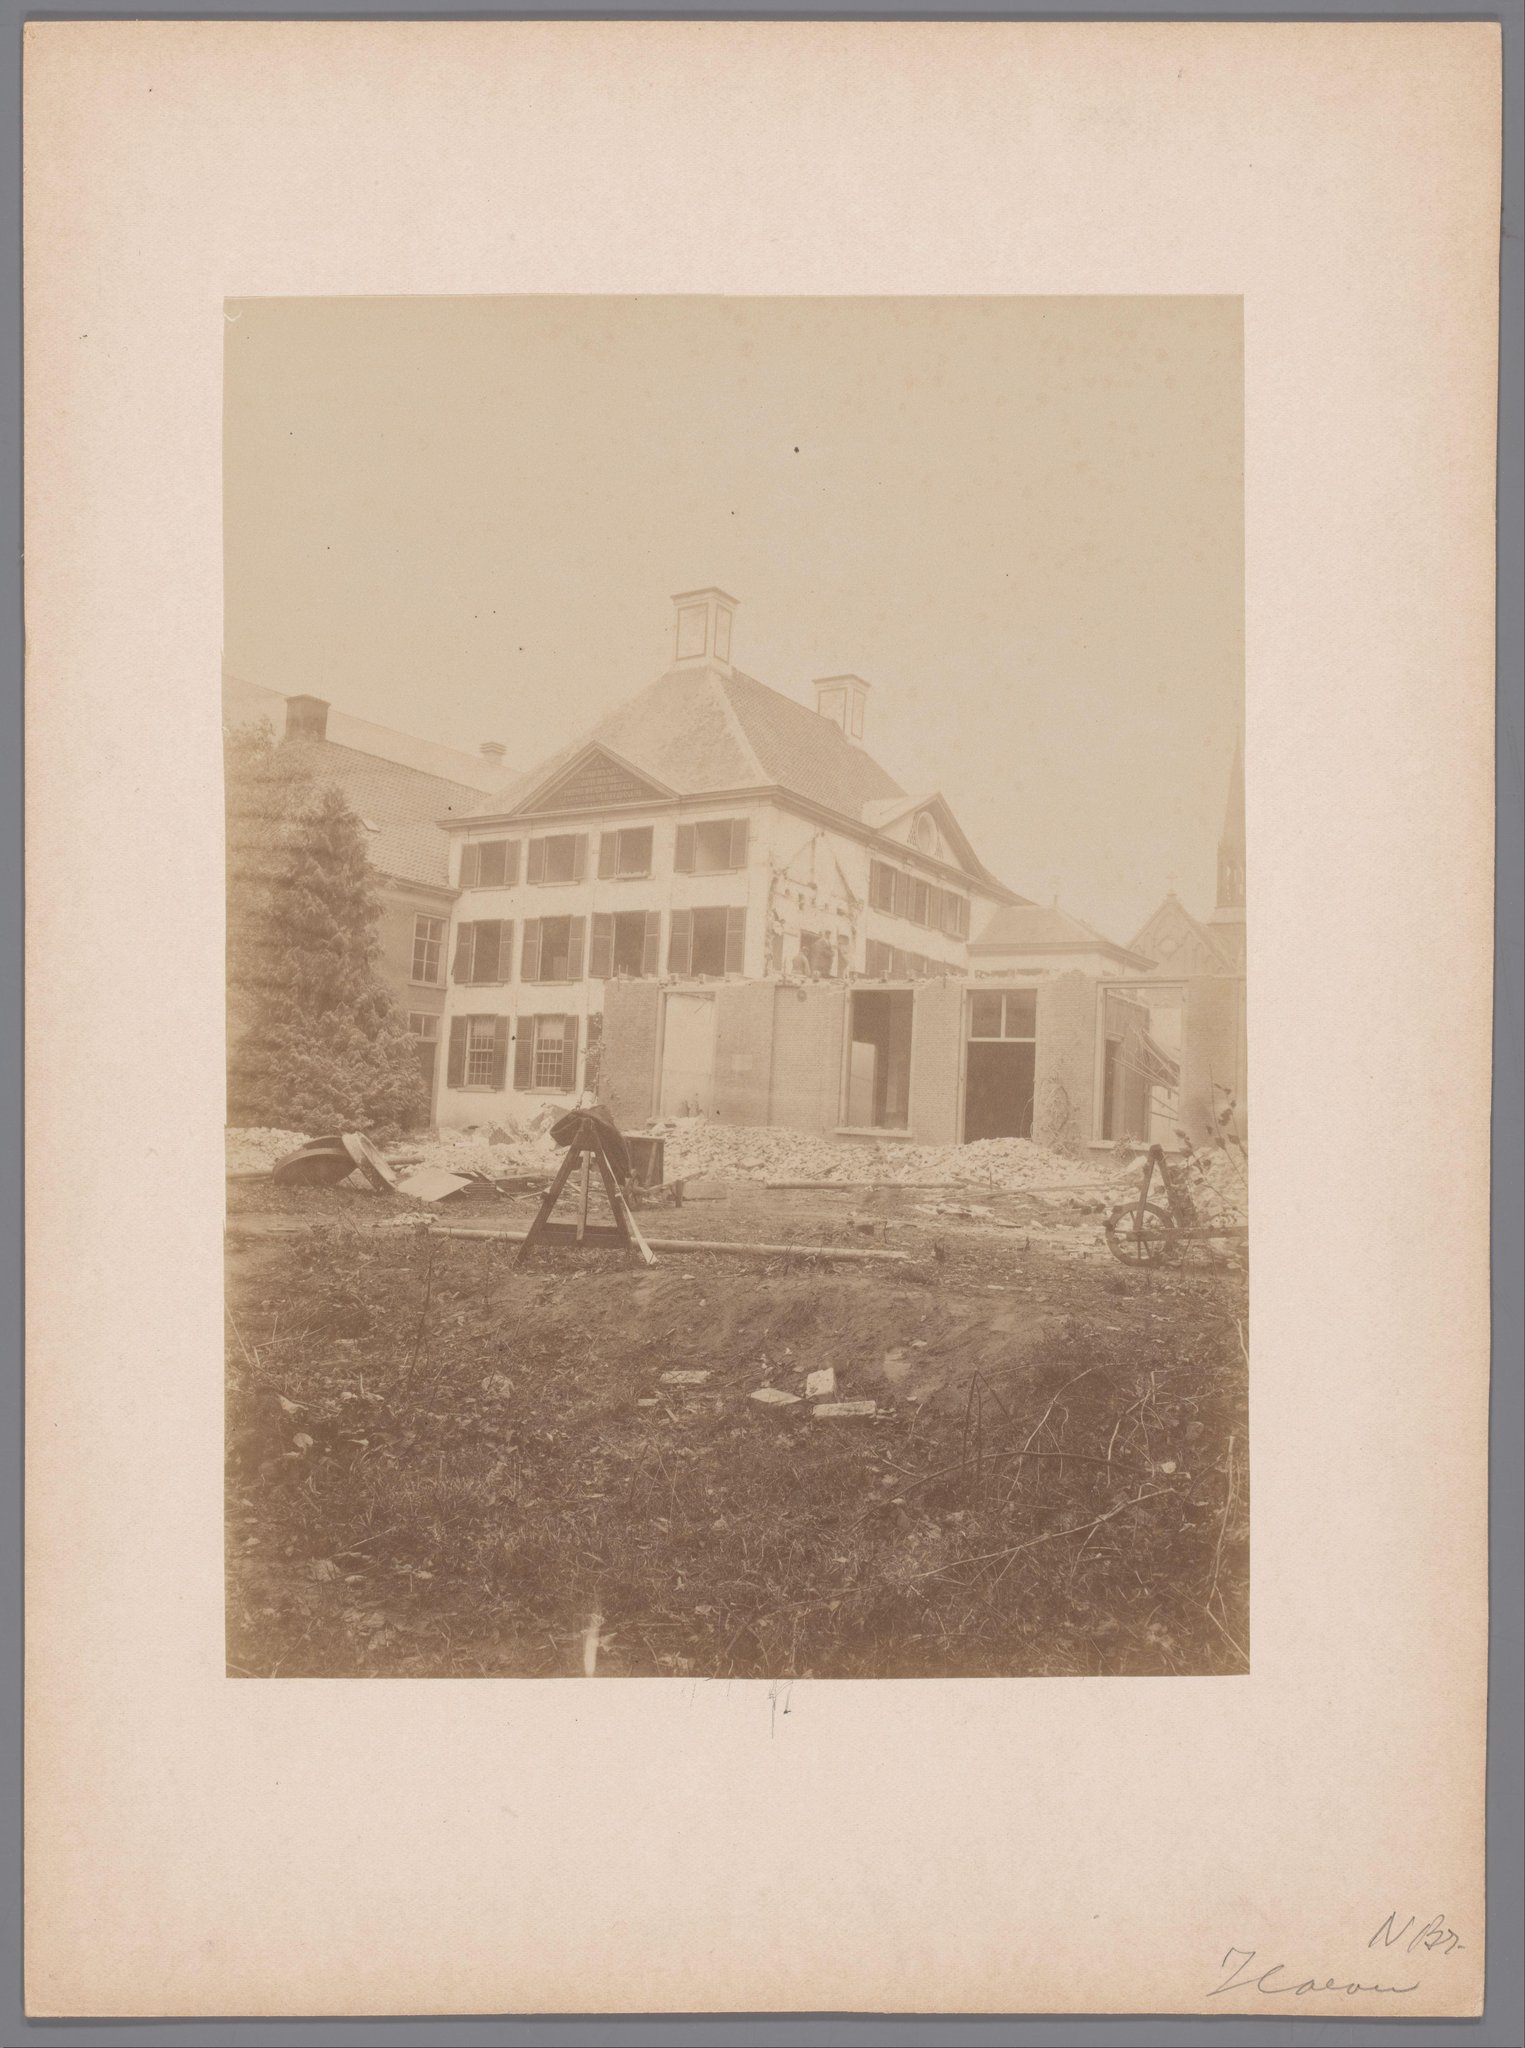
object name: photograph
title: Seminarie van het bisdom Breda en voormalig buitenverblijf van de bisschop van Antwerpen te Hoeven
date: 1904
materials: cardboard, photographic support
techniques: albumen print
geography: hoeven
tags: institution for ecclesiastical education and training, e.g. seminary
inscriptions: annotation: ‘Buitenverblijf v/d Bisschop van Antwerpen / thans Seminarie v/h Bisdom Breda / afgebroken 1904 / Hoeven (NB)’, annotation: ‘Hoeven N.Br.’